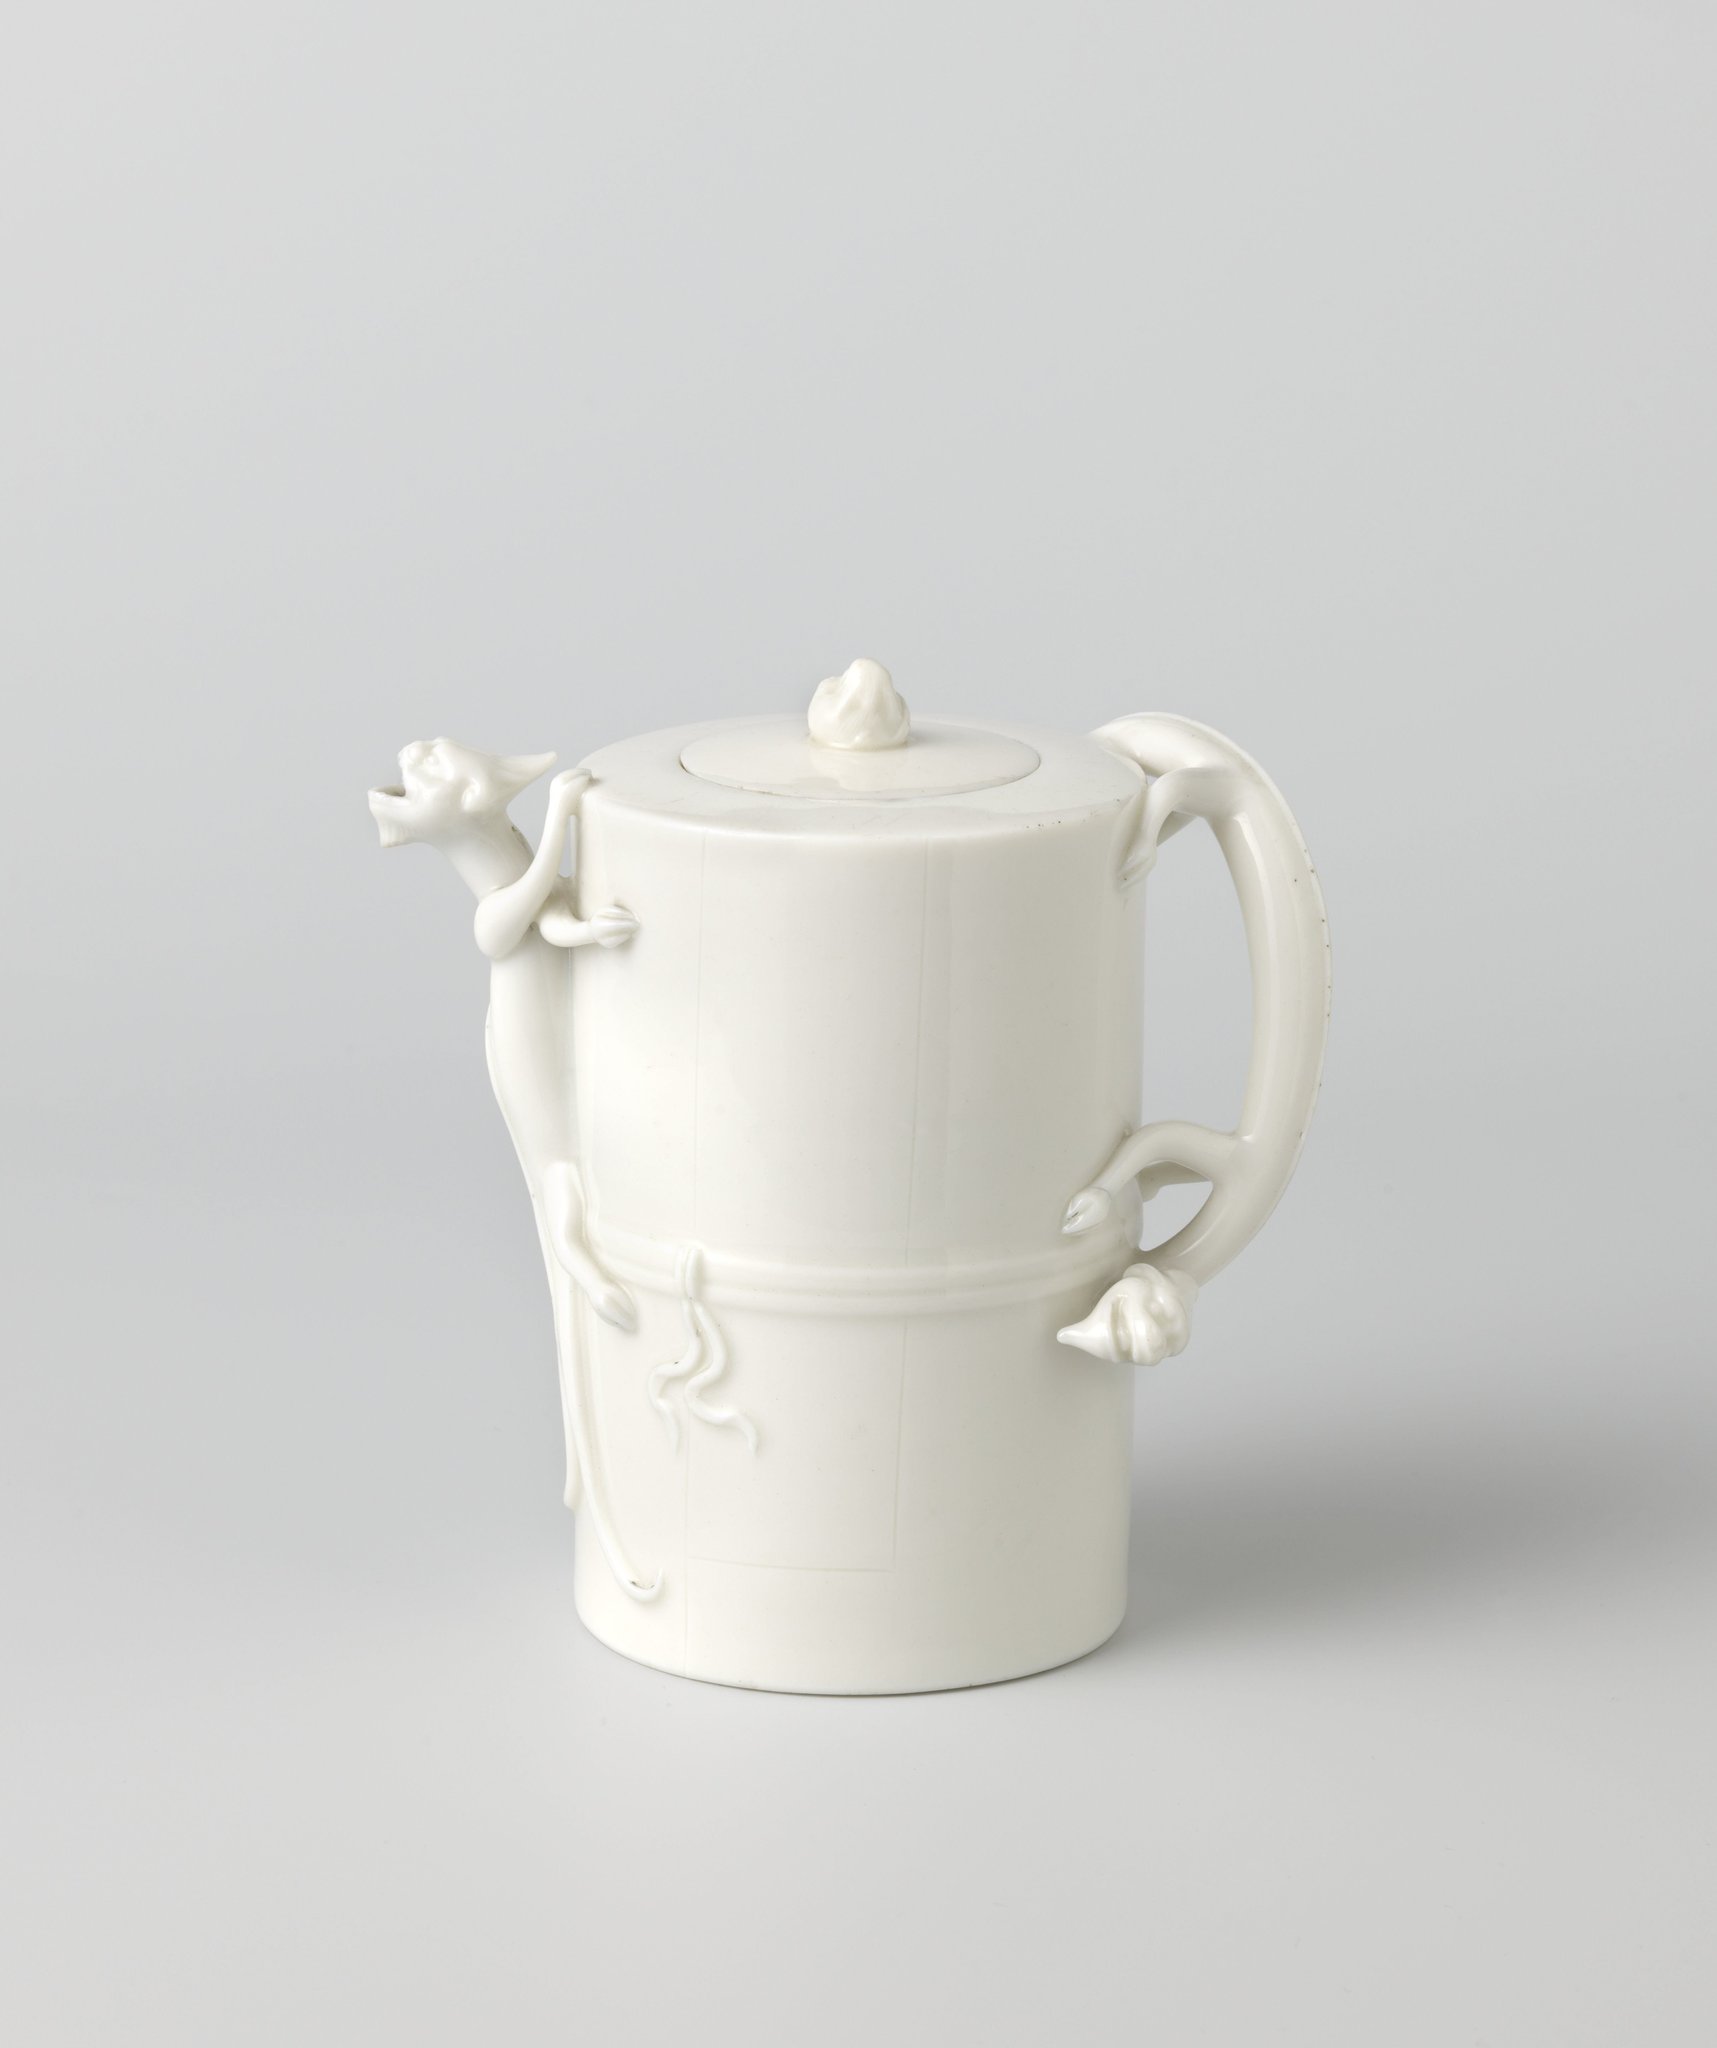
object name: ewer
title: Cylindrical wine ewer with dragon-shaped spout and handle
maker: Anonymous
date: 1662-1699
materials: glaze, porcelain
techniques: forming, turning, vitrification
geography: dehua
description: Wijnkan met deksel van porselein. 'Blanc de Chine'. De tuit en het oor worden gevormd door een klimmende en een dalende kameleon. Het deksel heeft als knop een kameleonmasker.